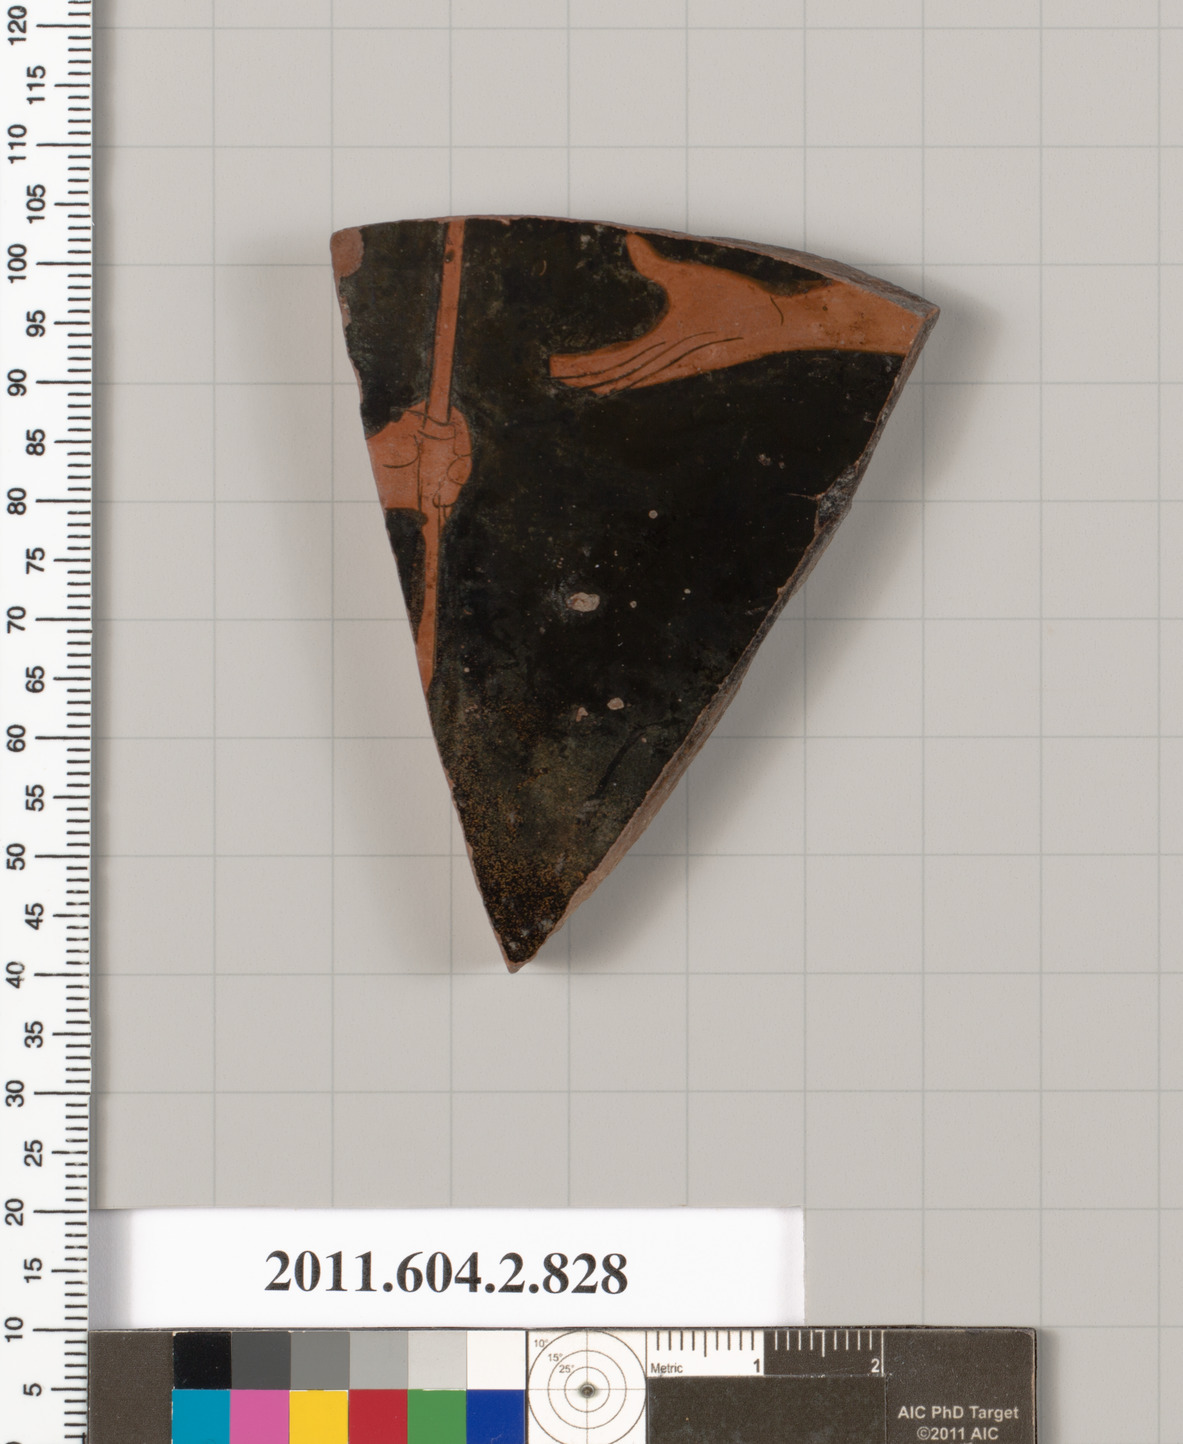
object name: bell krater fragment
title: Terracotta fragment of a bell-krater (bowl for mixing wine and water)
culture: greek, attic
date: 460-440 BCE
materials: terracotta